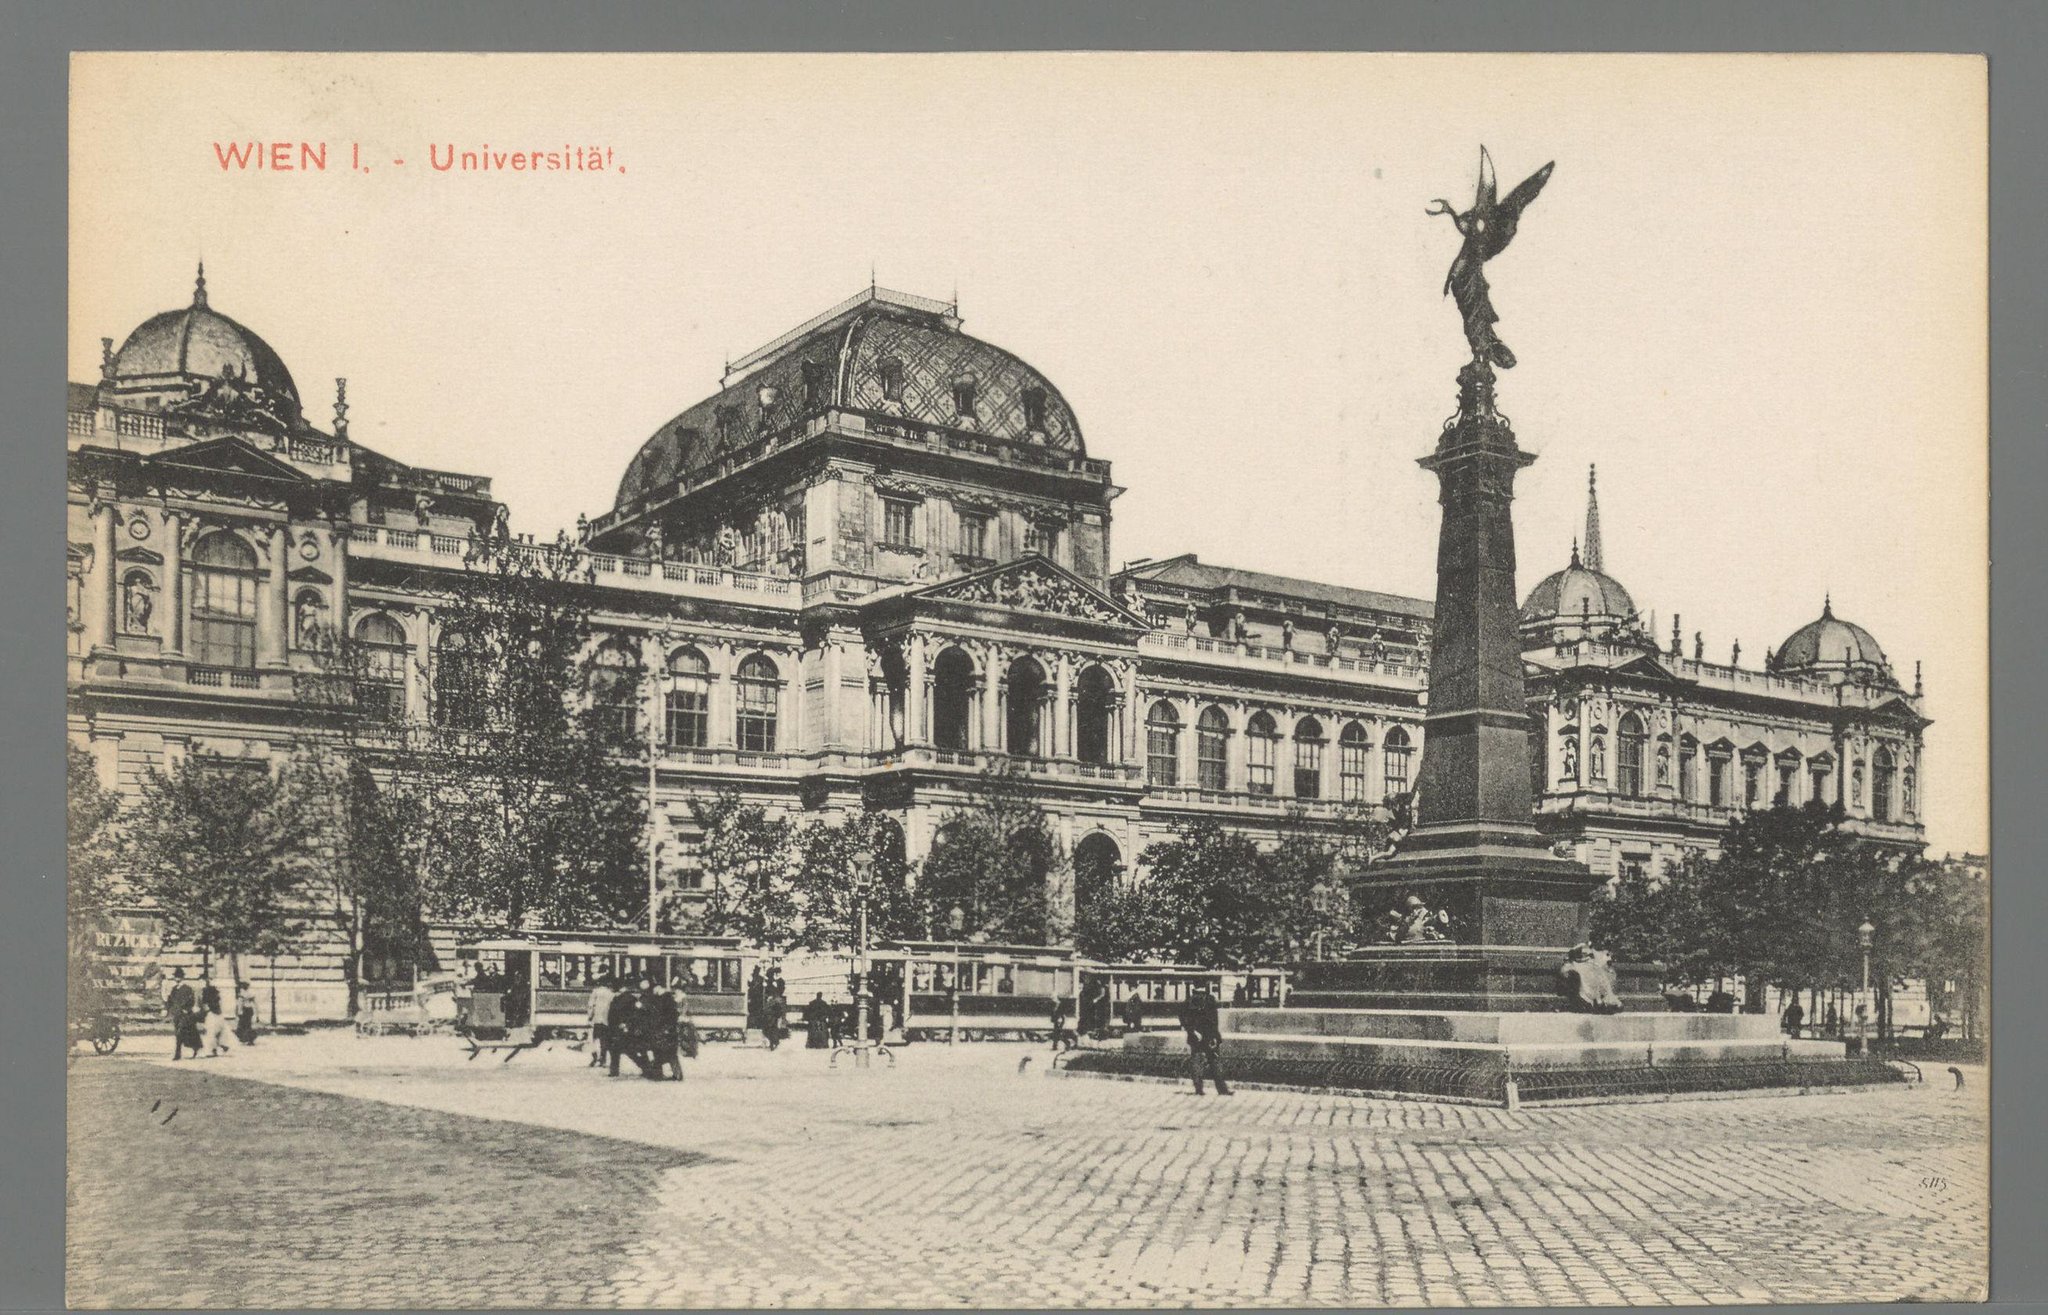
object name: ansichtkaart, prentbriefkaart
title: Wien I. - Universität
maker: Anonymous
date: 1904-1930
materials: cardboard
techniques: photograph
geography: vienna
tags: monument, statue, university building, college